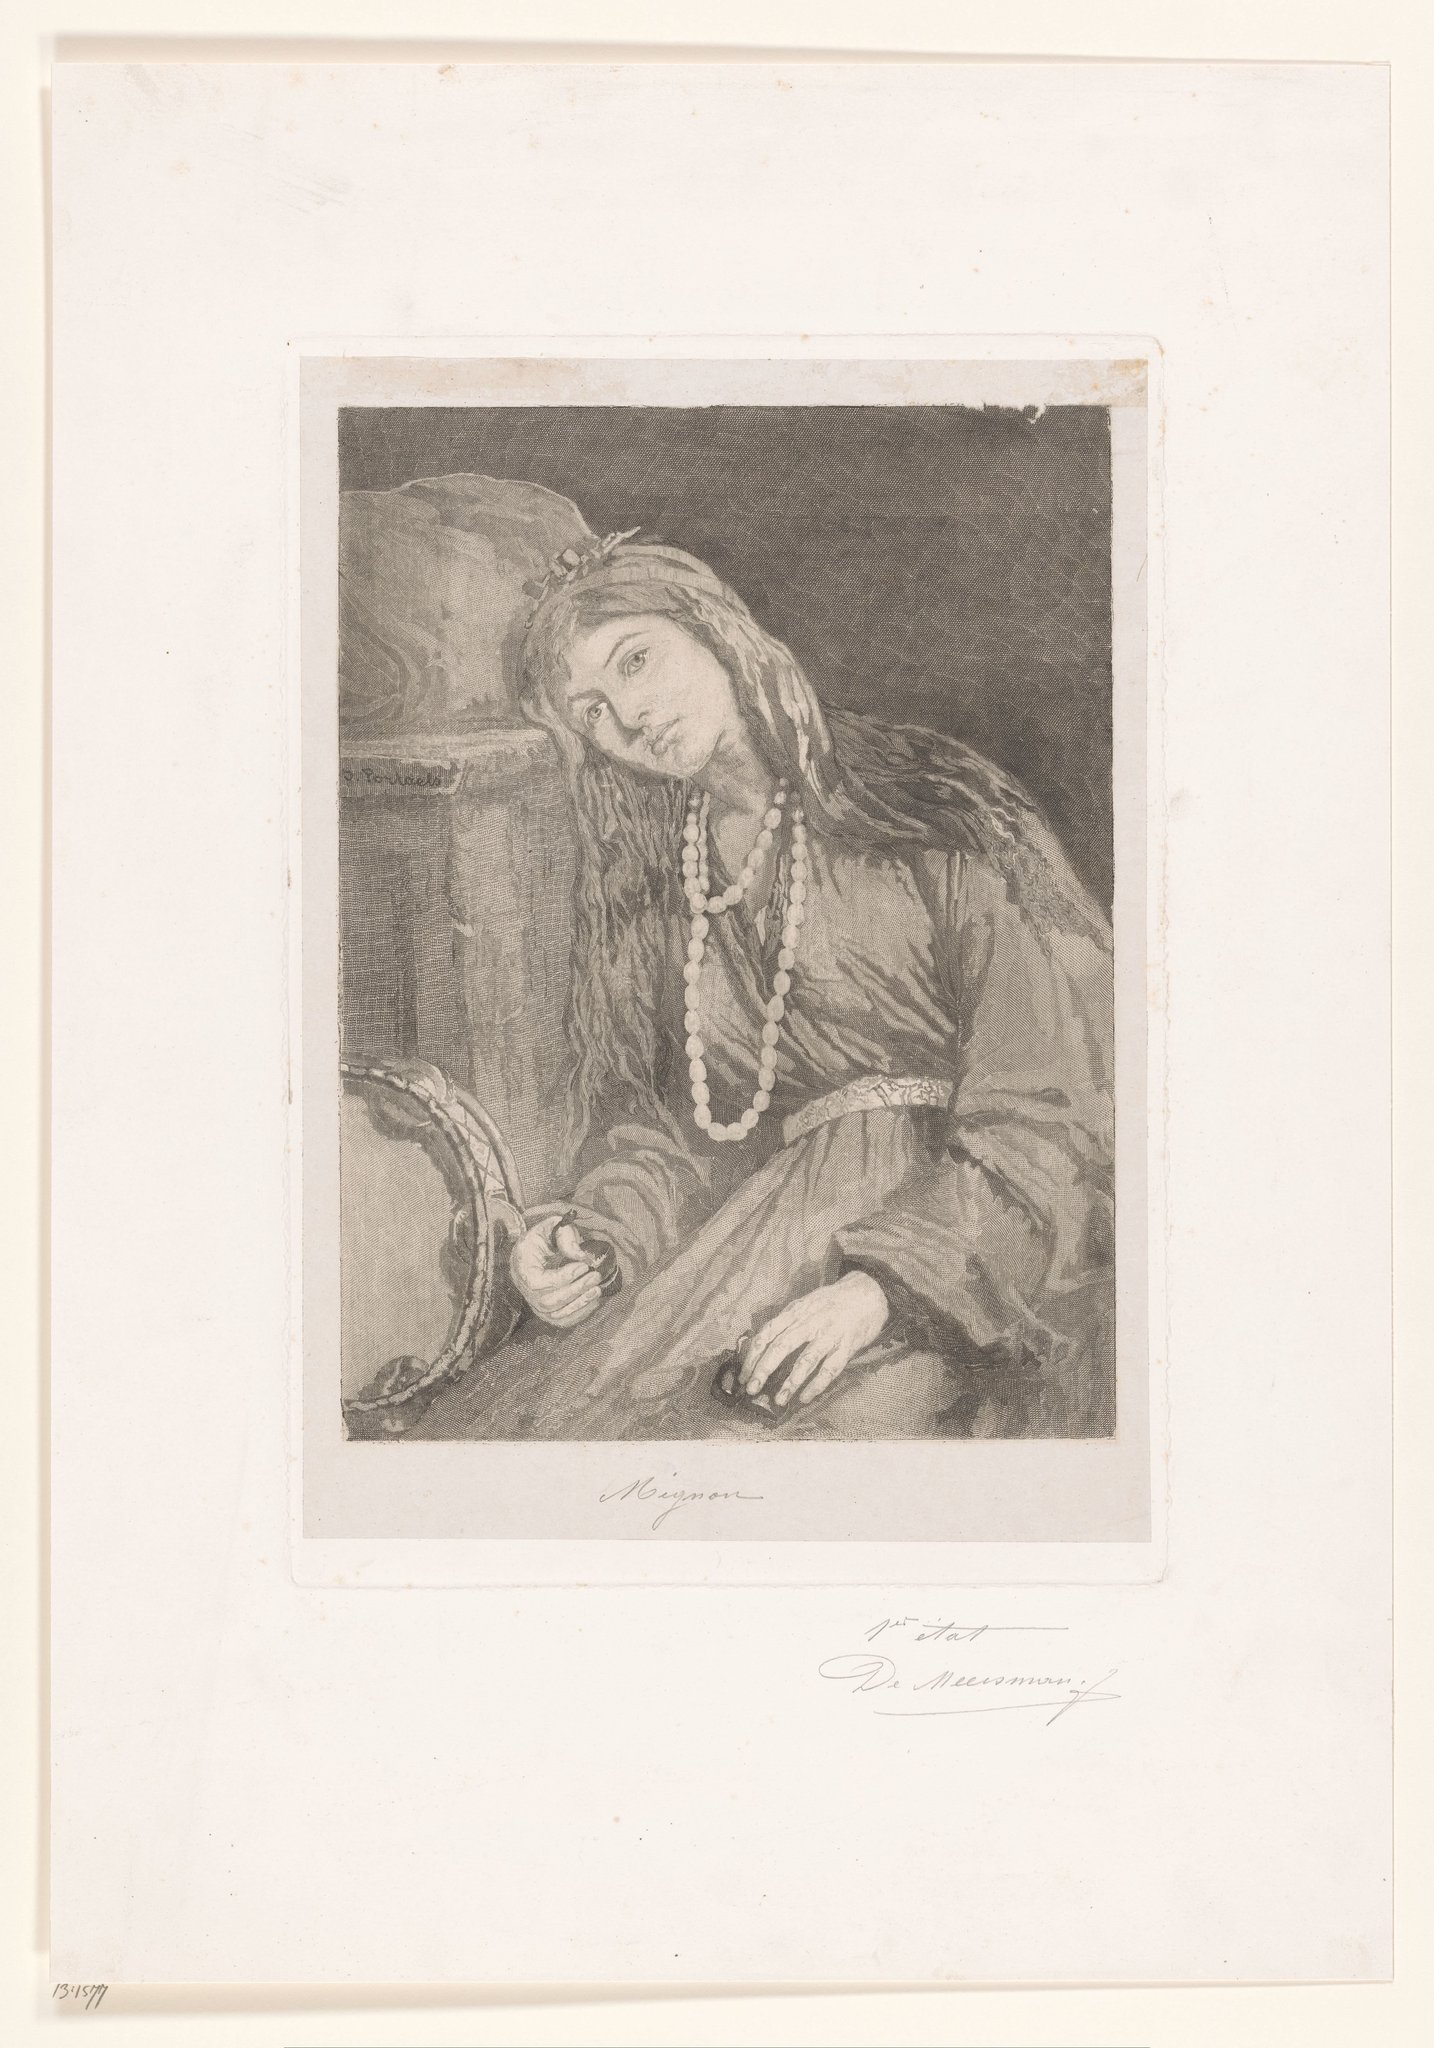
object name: print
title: Rustende muzikante met castagnetten en tamboerijn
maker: françois de meersman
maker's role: print maker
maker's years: 1830-1905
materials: paper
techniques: etching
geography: belgium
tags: adolescent, young woman, maiden, tambourine, clappers, castanets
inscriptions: annotation: ‘1er état’, collector's mark: Lugt 2228